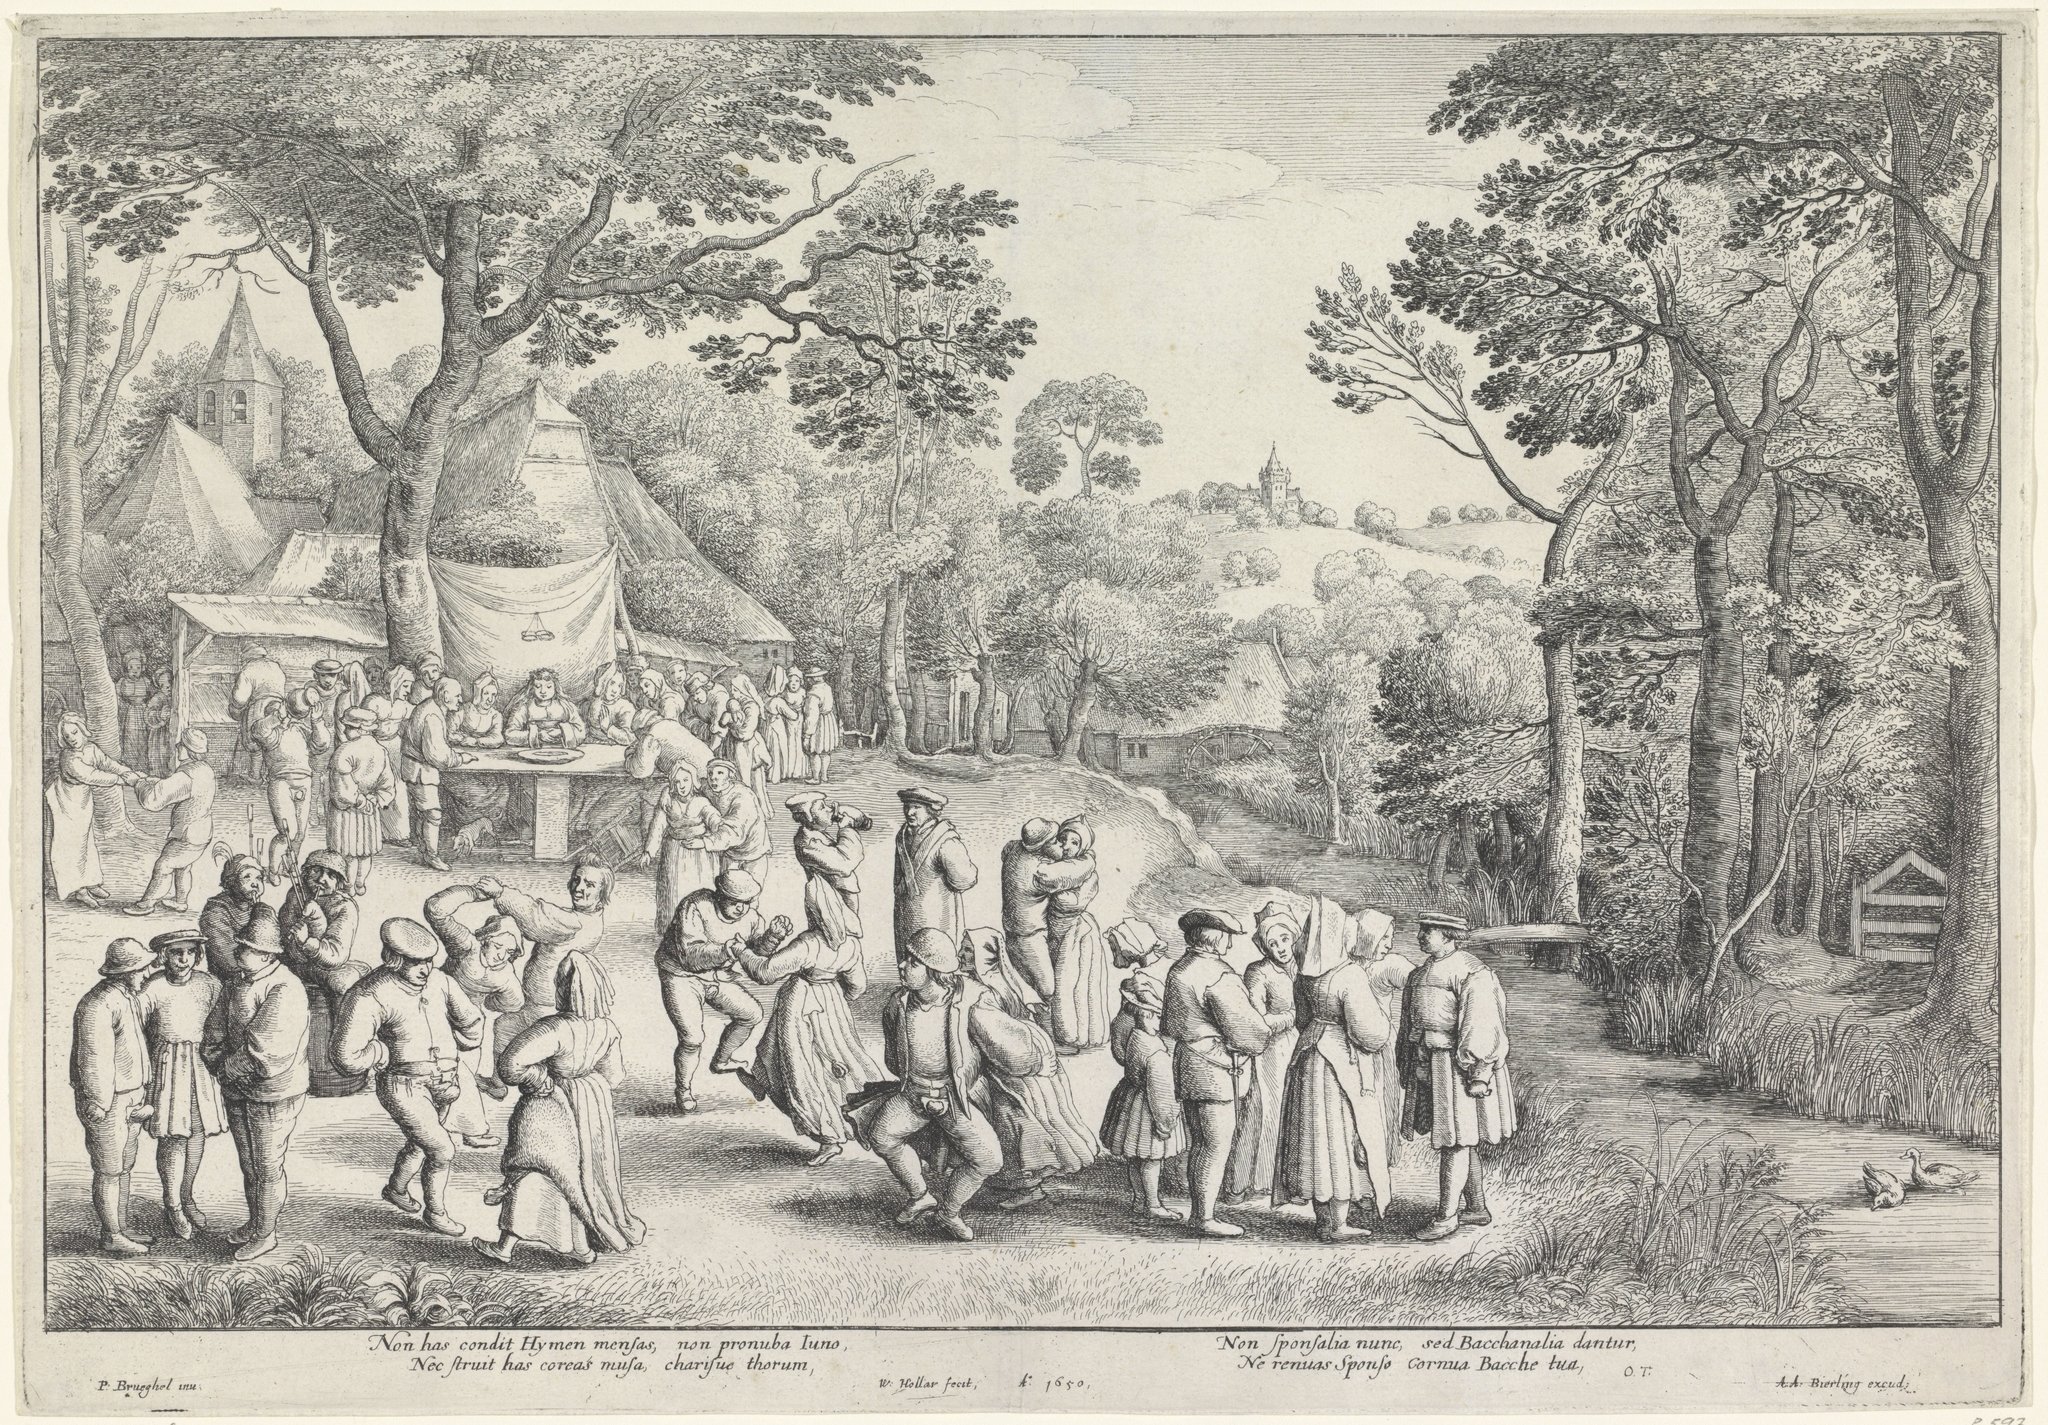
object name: print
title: Boerenbruiloft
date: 1650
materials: paper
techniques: etching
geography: antwerp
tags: wedding feast, wedding meal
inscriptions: collector's mark: Lugt 240